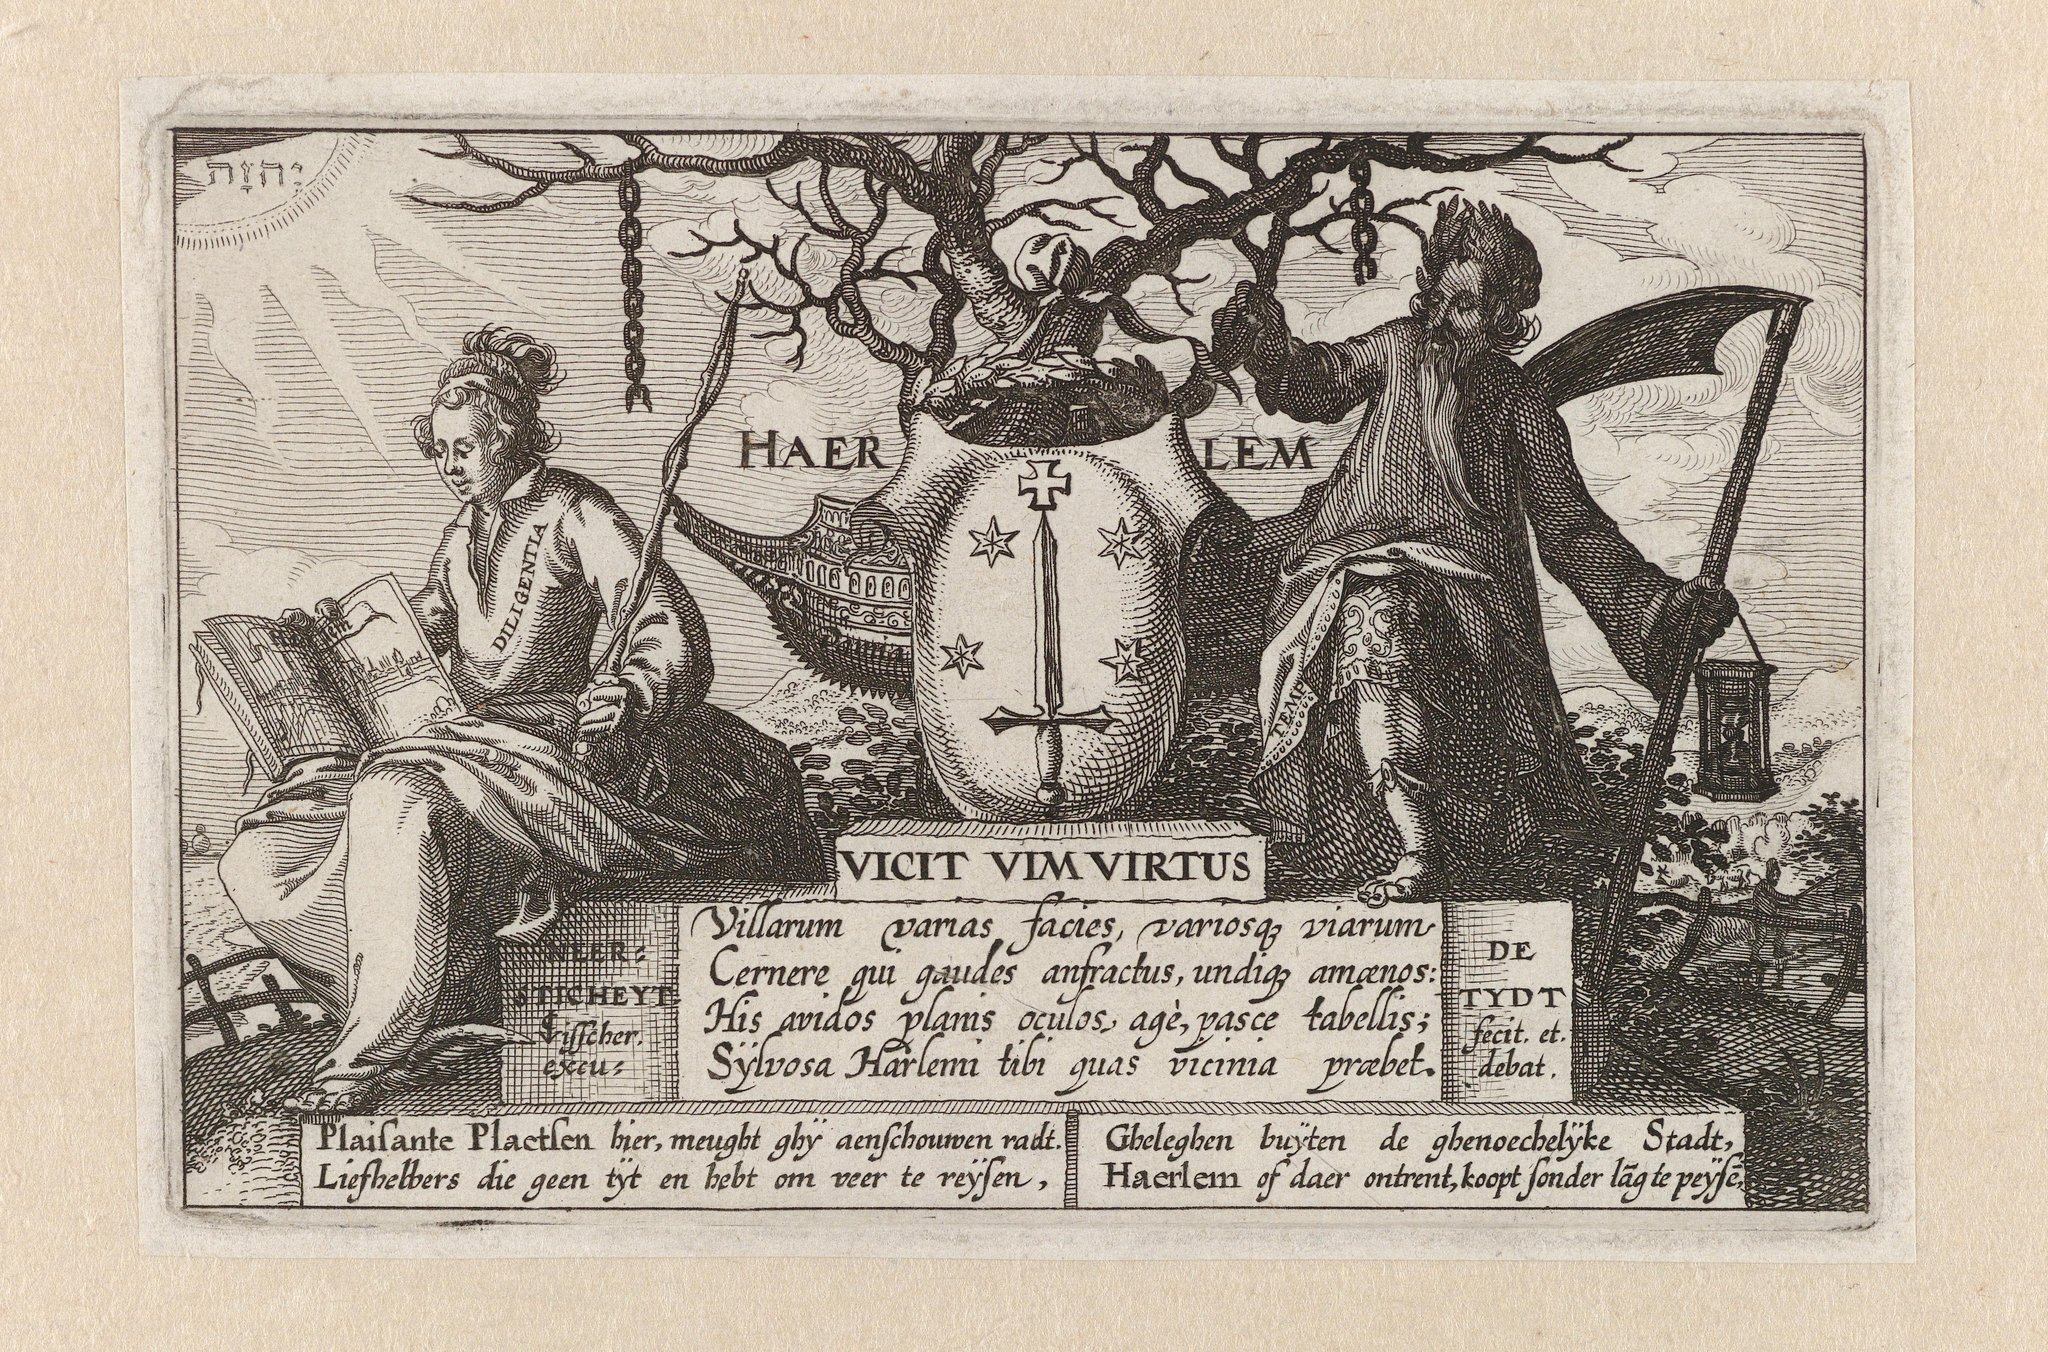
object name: print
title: Allegory of God's Creation, Haarlem, Time and Diligence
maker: claes jansz. visscher (ii)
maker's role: draughtsman, print maker, publisher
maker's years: 1586-1652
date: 1611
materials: paper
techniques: engraving, etching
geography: amsterdam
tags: illustration ~ printed matter, book, carefulness, diligence; 'diligenza' (ripa), device (as symbol of the state, etc.), father time, man with wings and scythe, haarlem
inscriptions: collector's mark: 2228, title: ‘HAERLEM VICIT VIM VICTUS’, signature and address: ‘CIVisscher fect. et. excudebat.’ Lugt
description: In het midden het wapen van Haarlem, bekroond met een lauwerkrans en boomtakken. Achter het wapen een schip en de tekst HAERLEM. Onder het wapen: VICIT VIM VIRTUS. In het midden vier regelige titel: Villarum varias facies...vicinia praebet. Links zit Naarstigheid of Diligentia met een open boek op schoot en staf in de hand. Rechts staat Tempus als gevleugelde oude man met zeis en zandloper Met bijschriften NEER=STICHEYT en DE TYDT. Vier regelige Nederlandse titel onderaan: Plaisante Plaetsen hier...sonder lag te peijse.